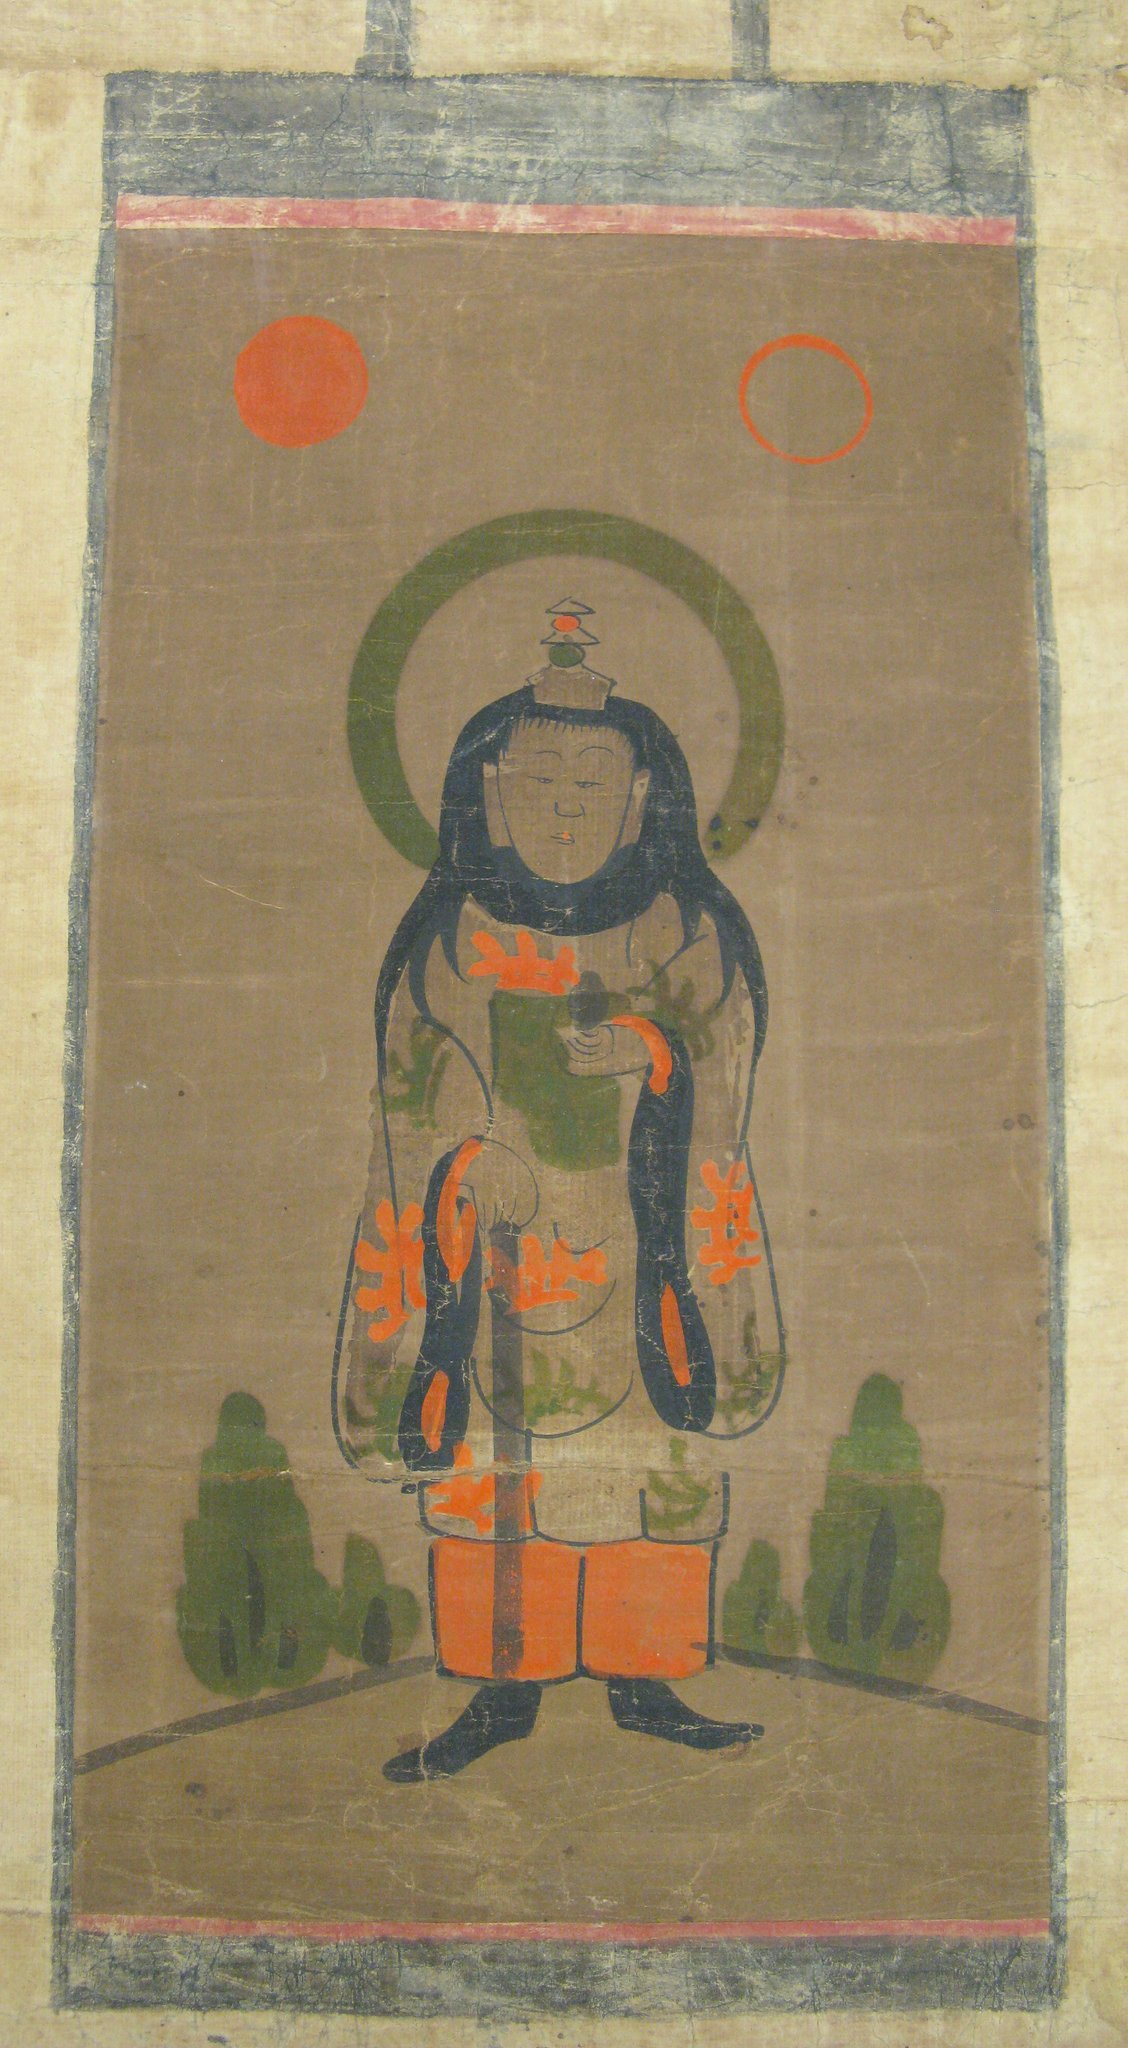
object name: hanging scroll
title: Ōtsu-e of Uhō Dōji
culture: japanese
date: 1601-1700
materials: ink, paper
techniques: woodblock print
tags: men